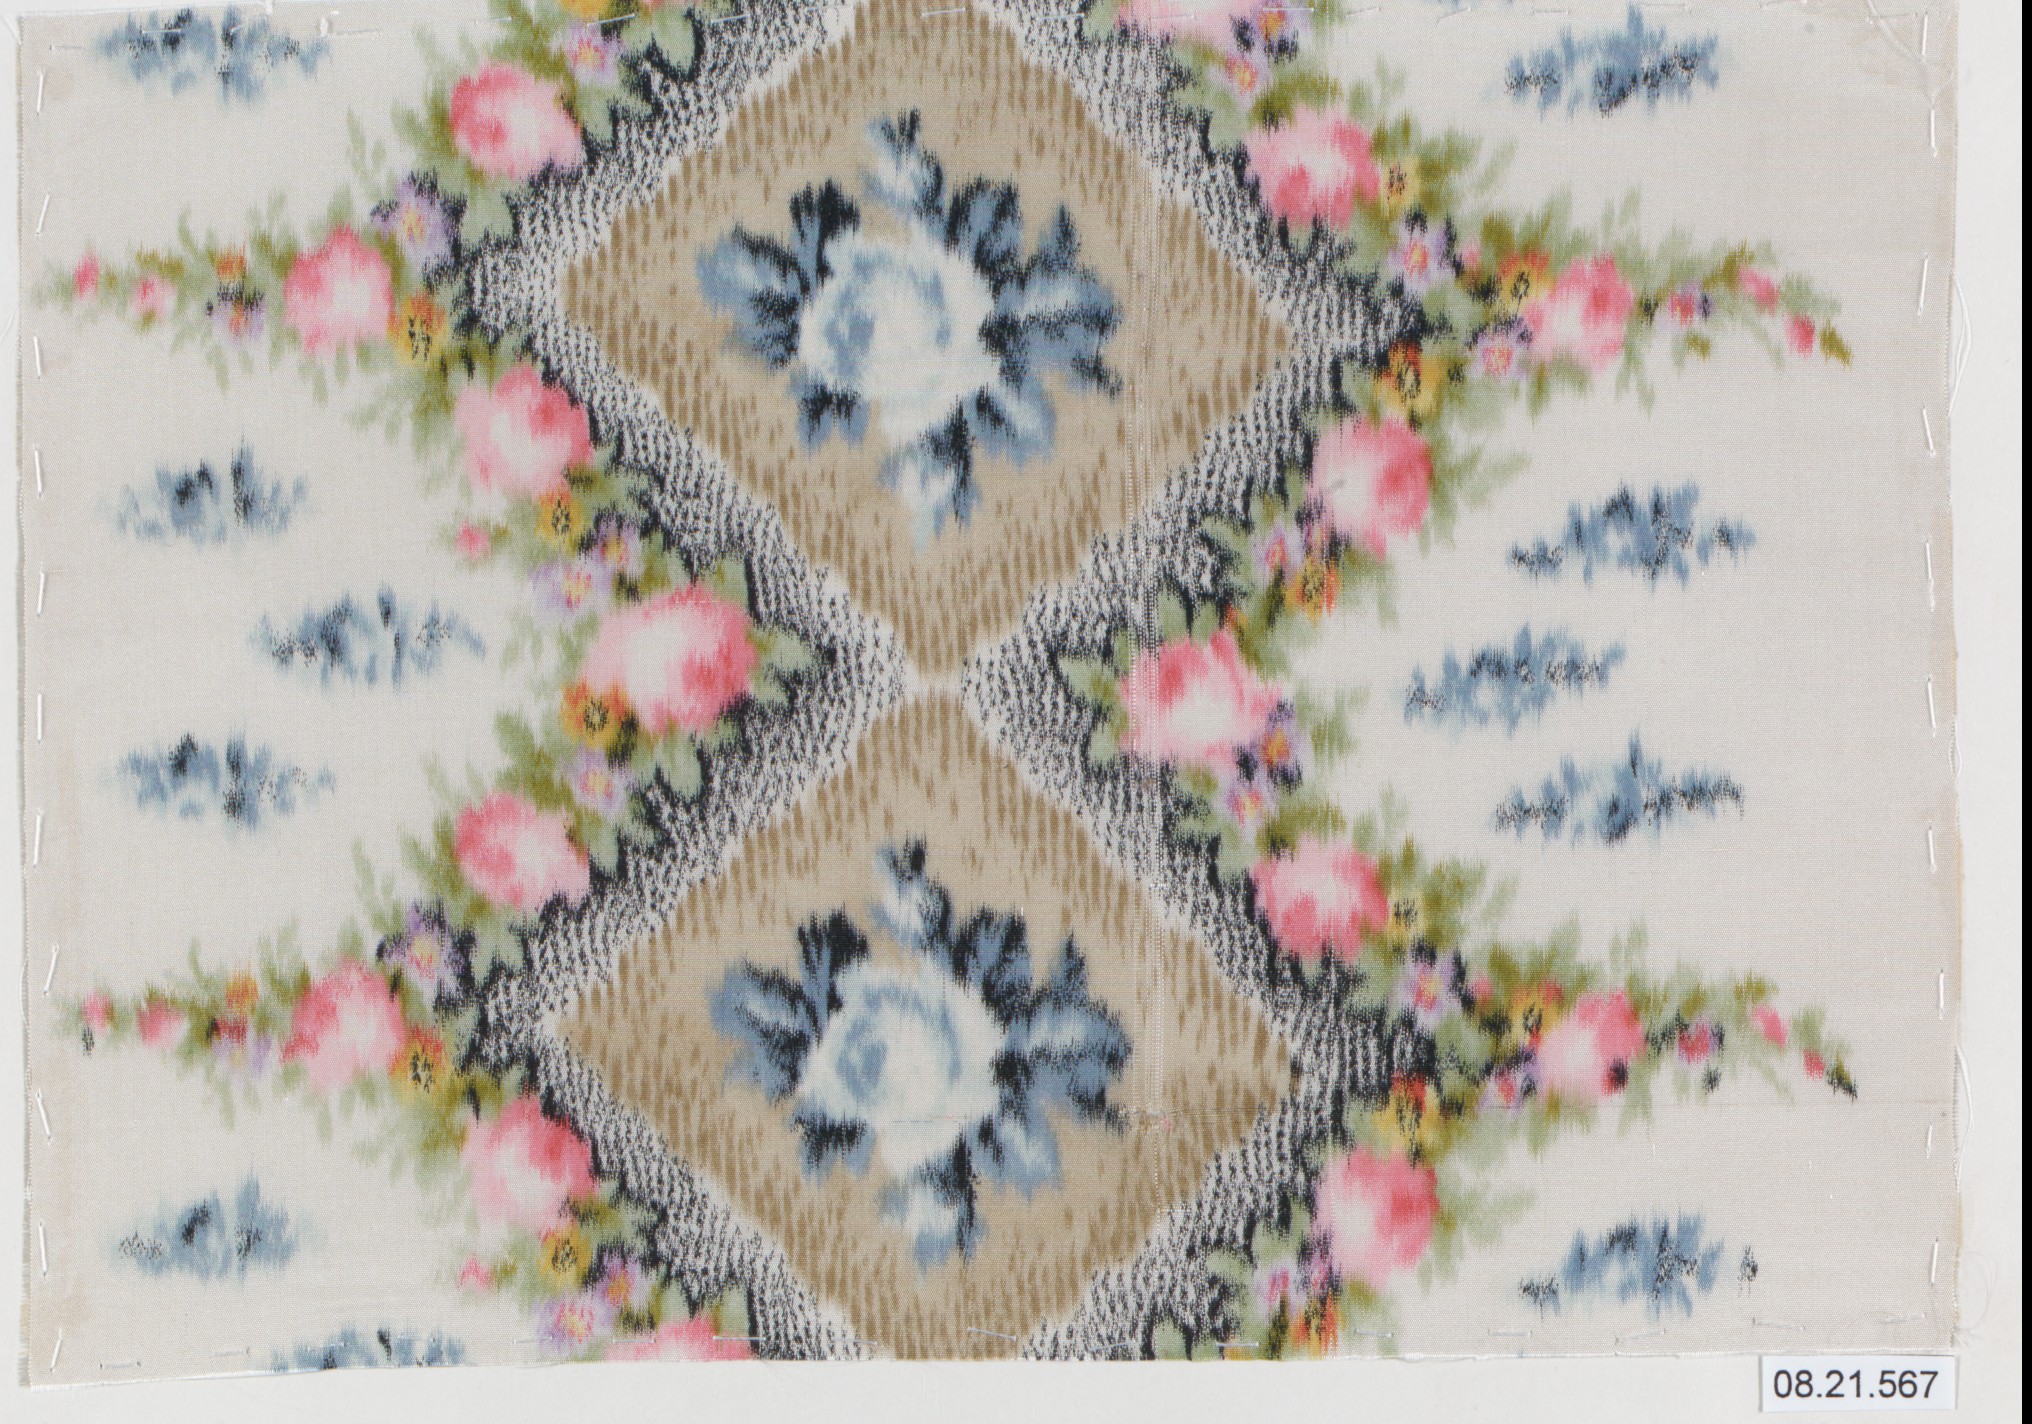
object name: textile sample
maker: Anonymous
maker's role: designer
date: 1900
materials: silk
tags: flowers